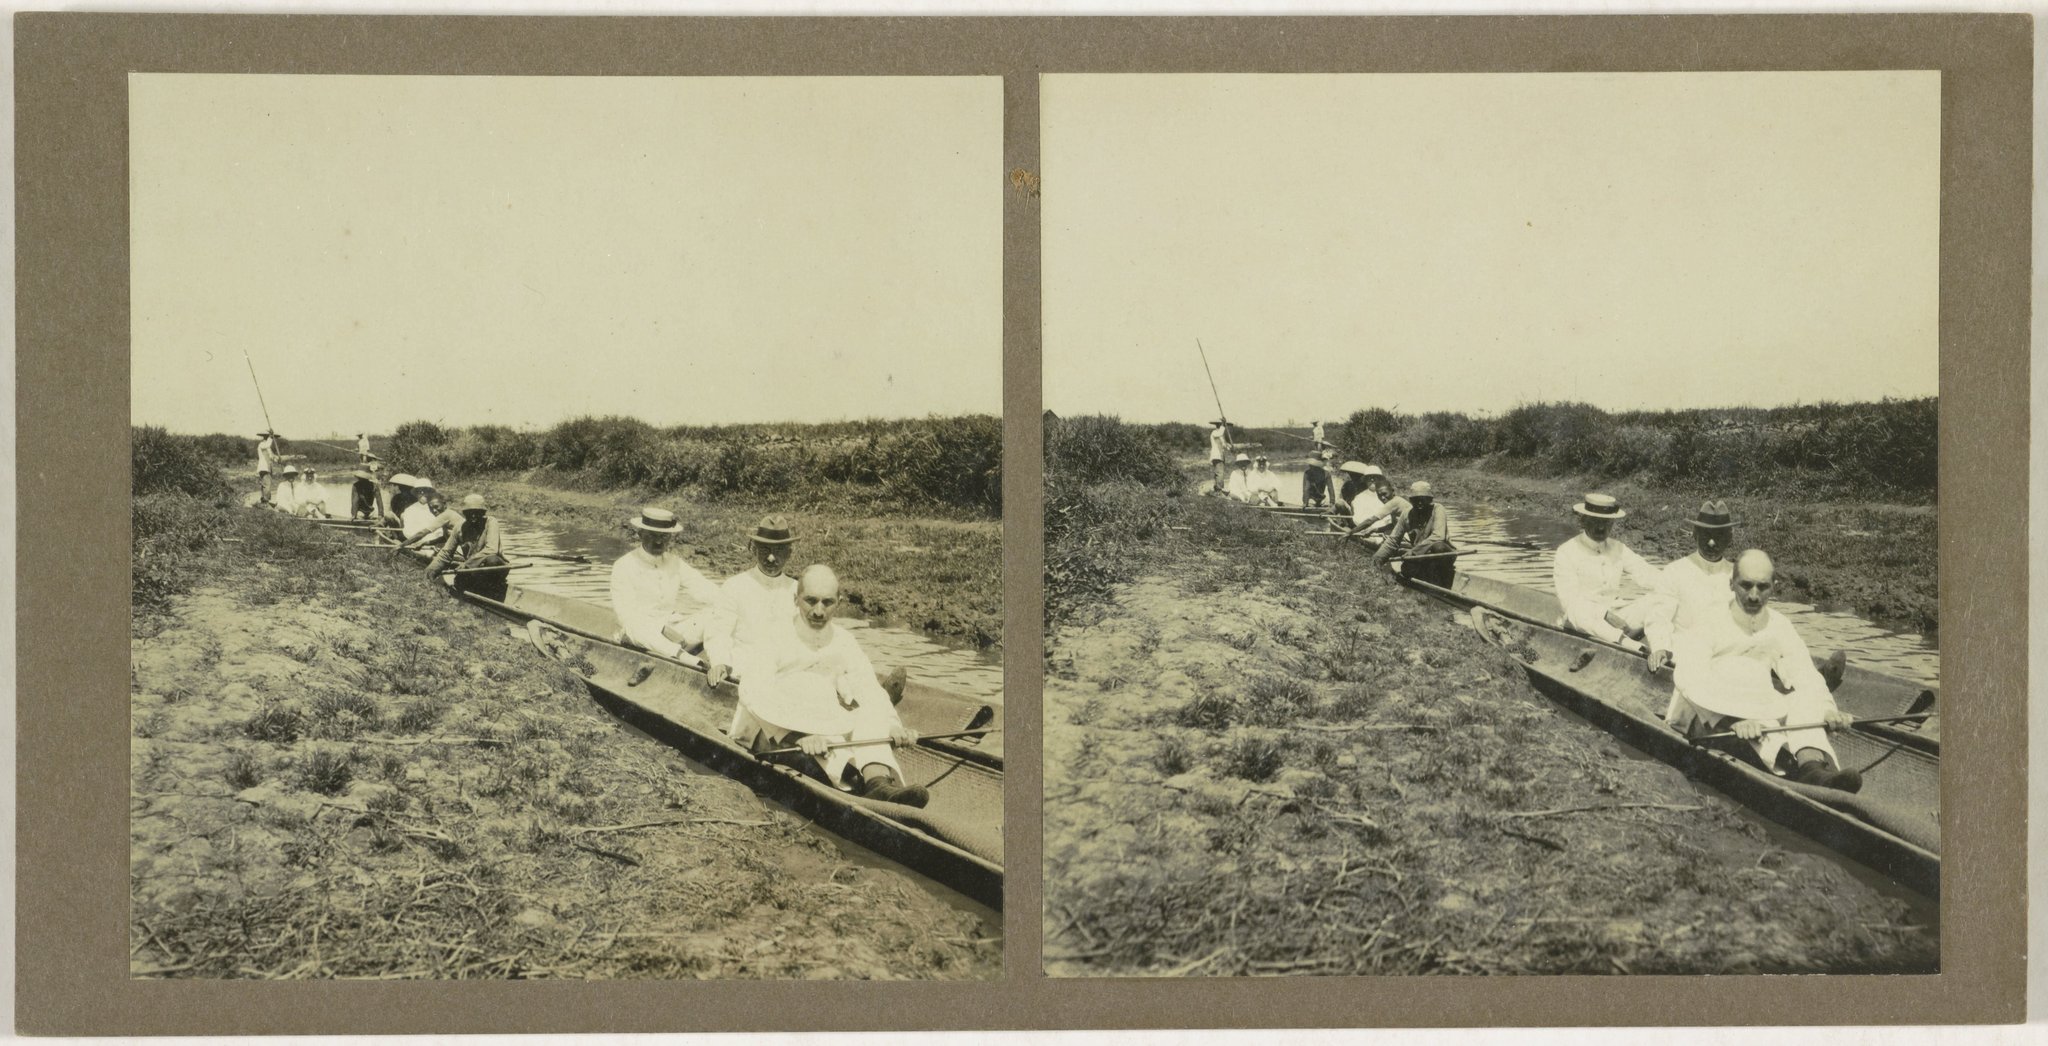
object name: stereograph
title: Ned. Indie, Borneo, enkele bootjes op smalle vaart, met zowel blanken als inheemsen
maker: Anonymous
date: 1900-1940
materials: paper, cardboard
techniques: gelatin silver print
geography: indonesia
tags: river, indonesia